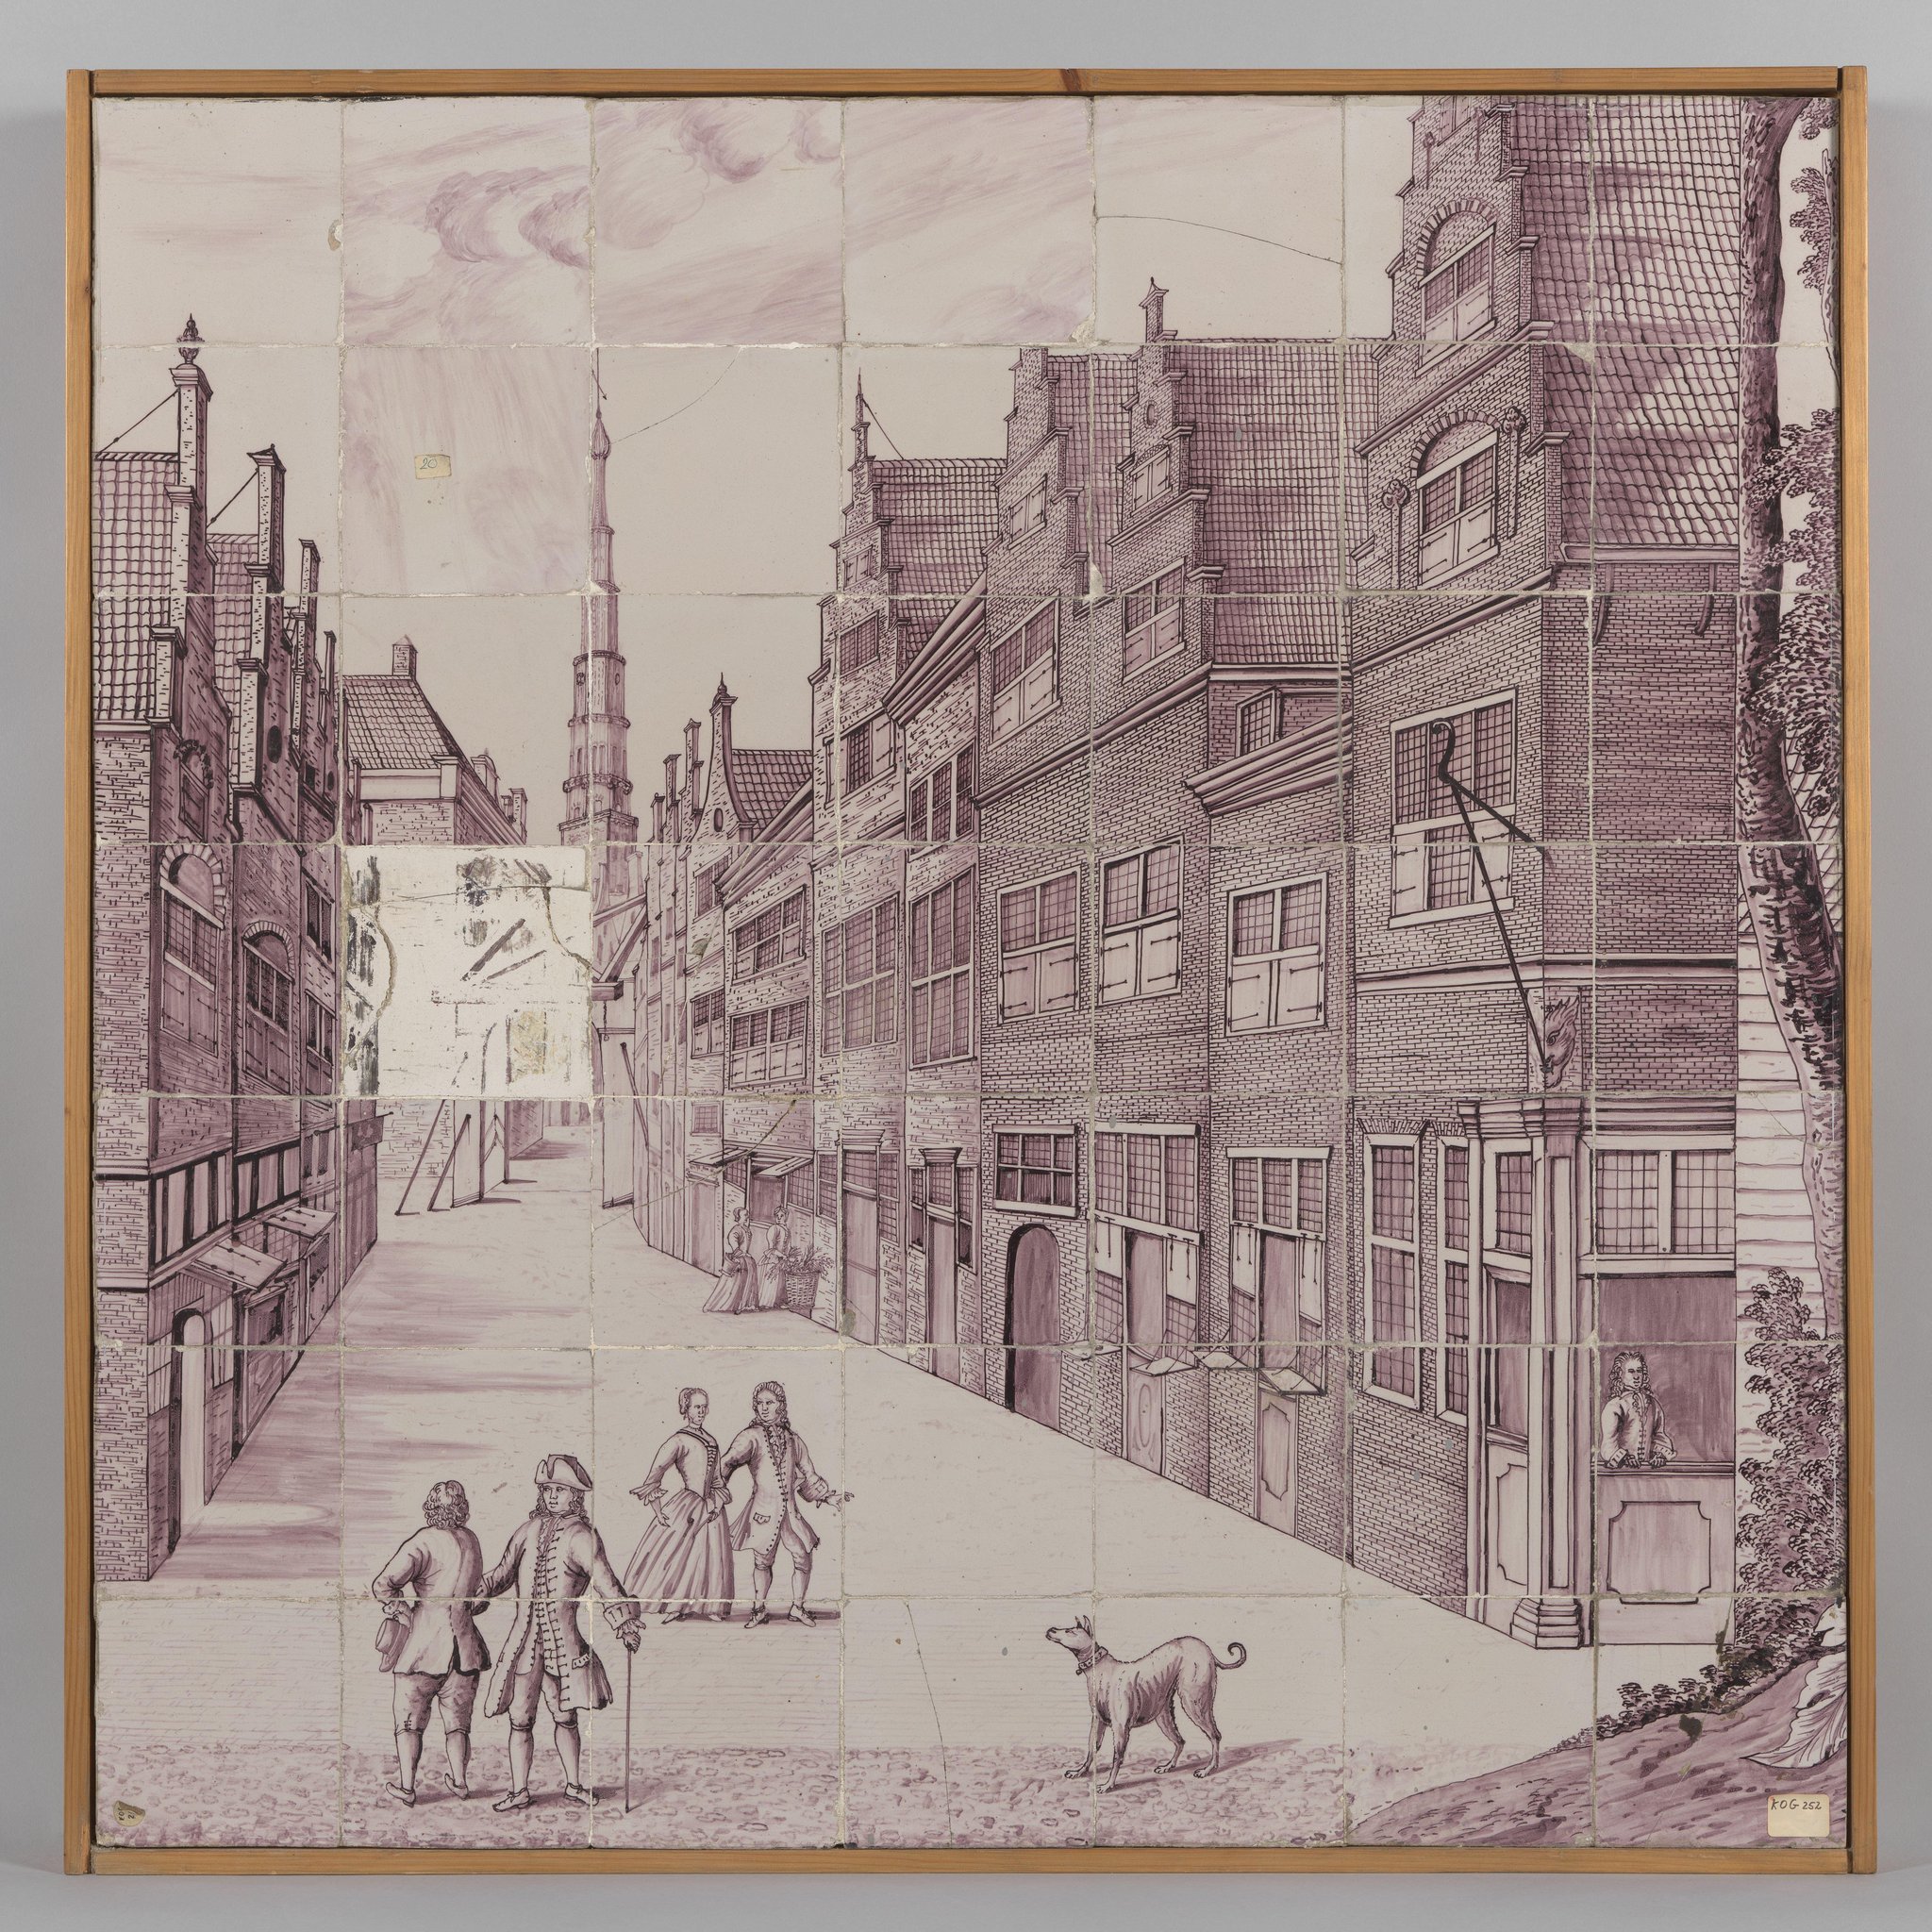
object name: tile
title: Tegeltableau van 49 tegels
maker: Anonymous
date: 1750-1800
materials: earthenware, glaze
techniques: maiolica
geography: netherlands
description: Tegeltableau van 49 tegels (7 x 7) met een paars geschilderd stadsgezicht van een straat met een toren aan het einde en figuren op de voorgrond.